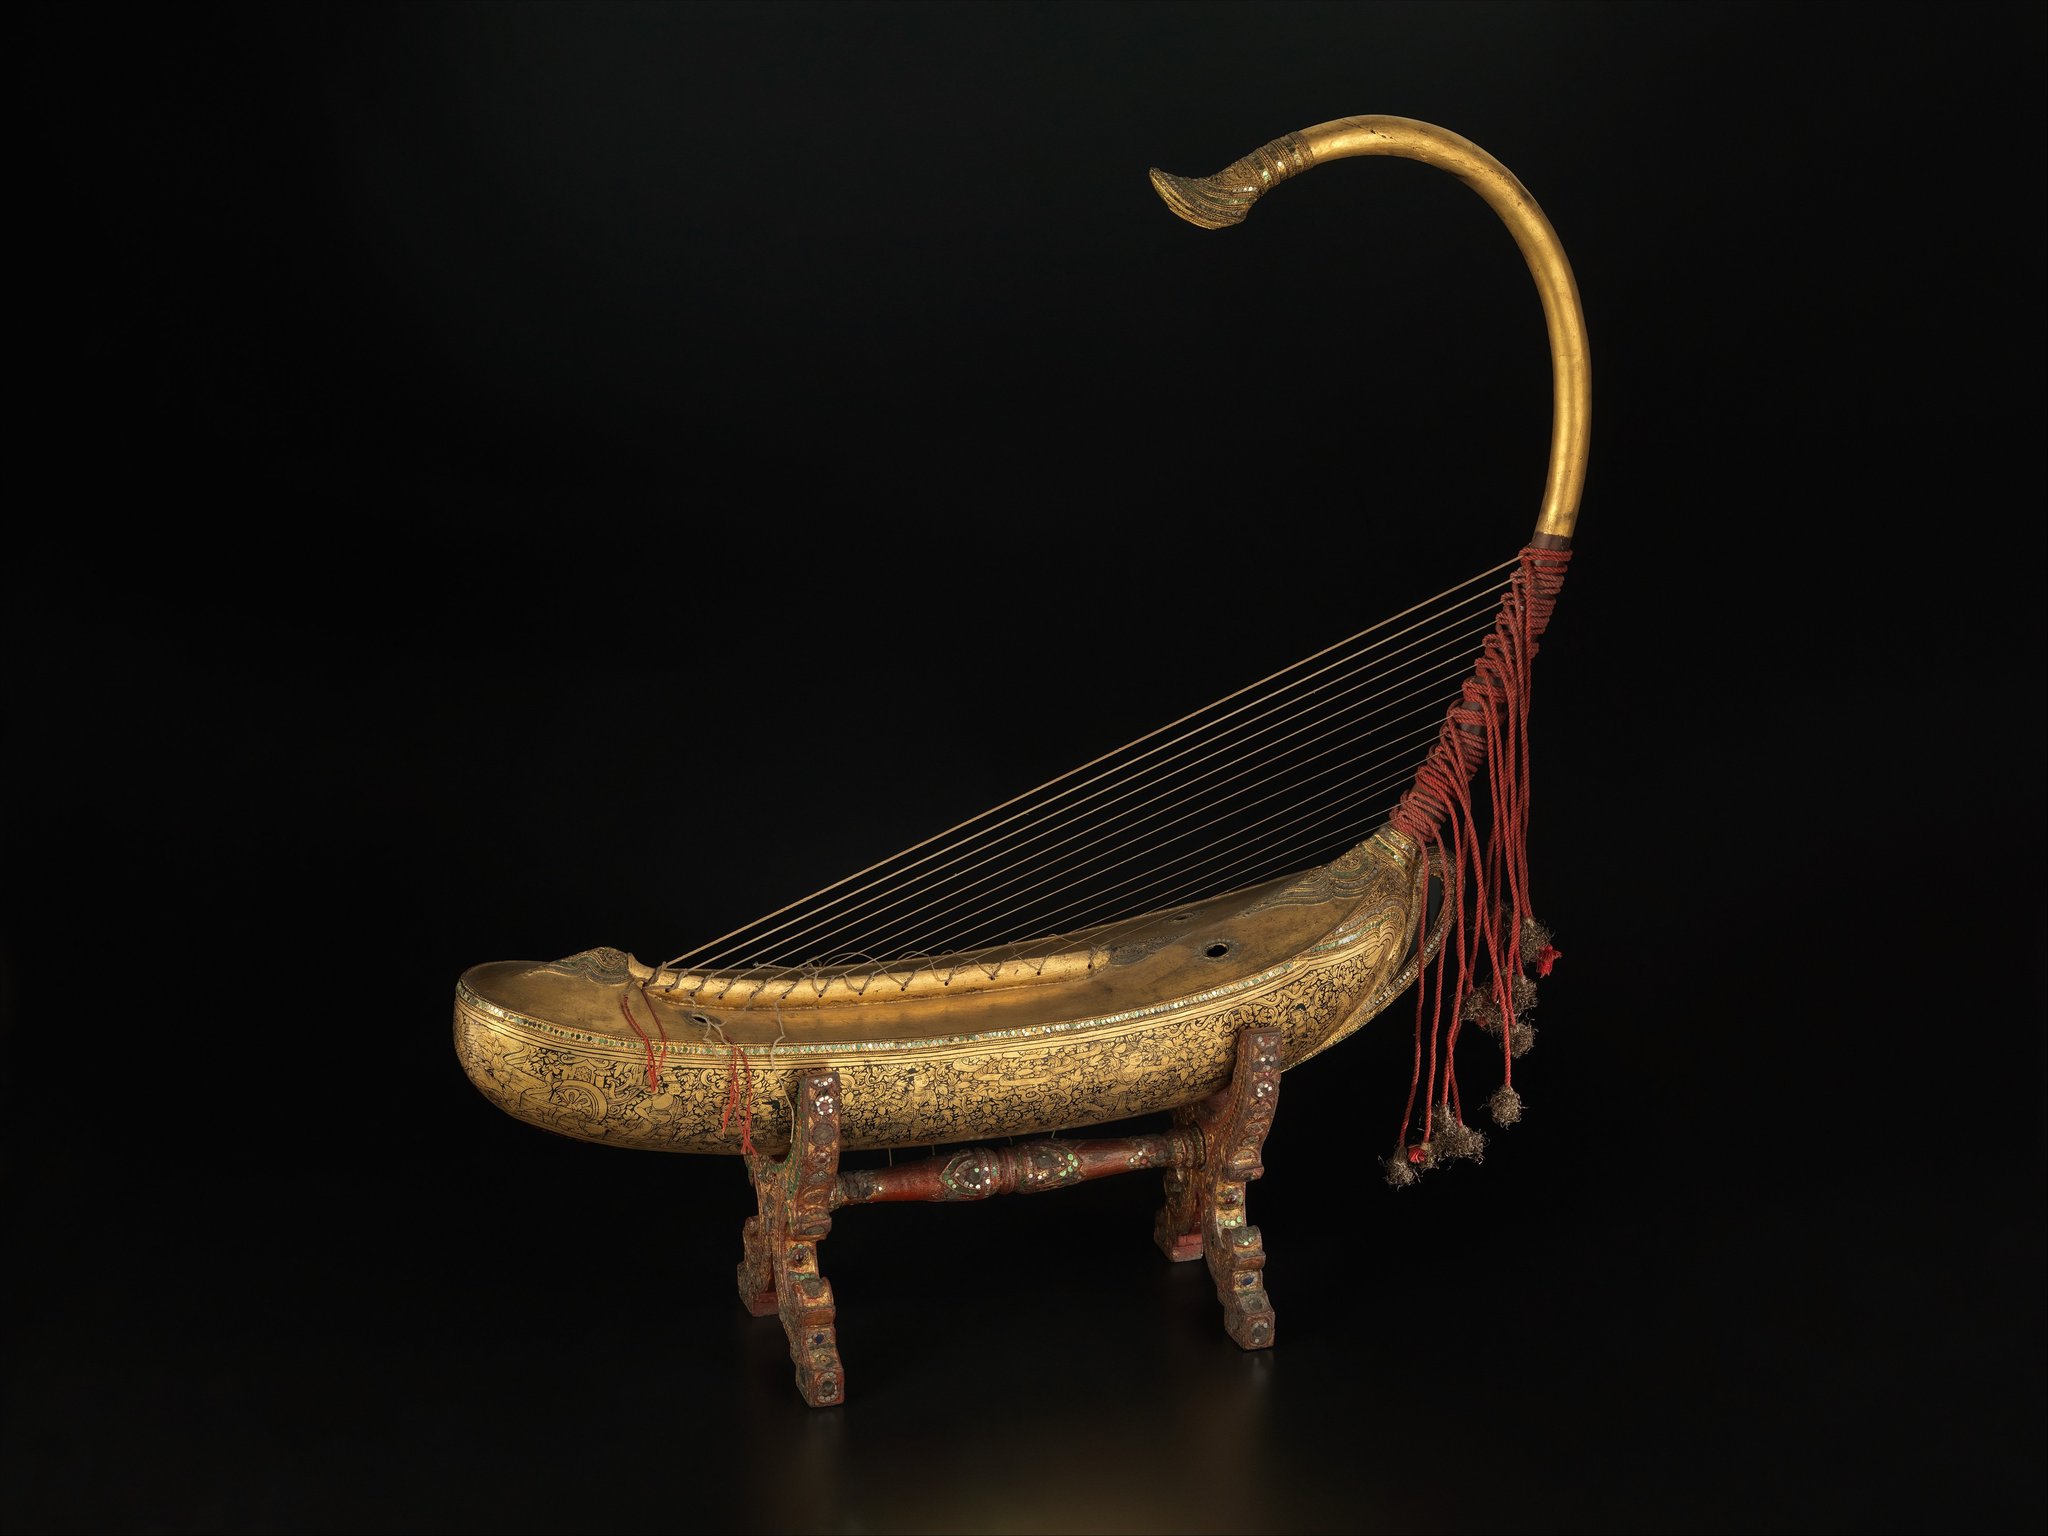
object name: saung gauk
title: Saùng-Gauk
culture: burmese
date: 1801-1900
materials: cord, cotton, glass, metal, paint, wood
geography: myanmar